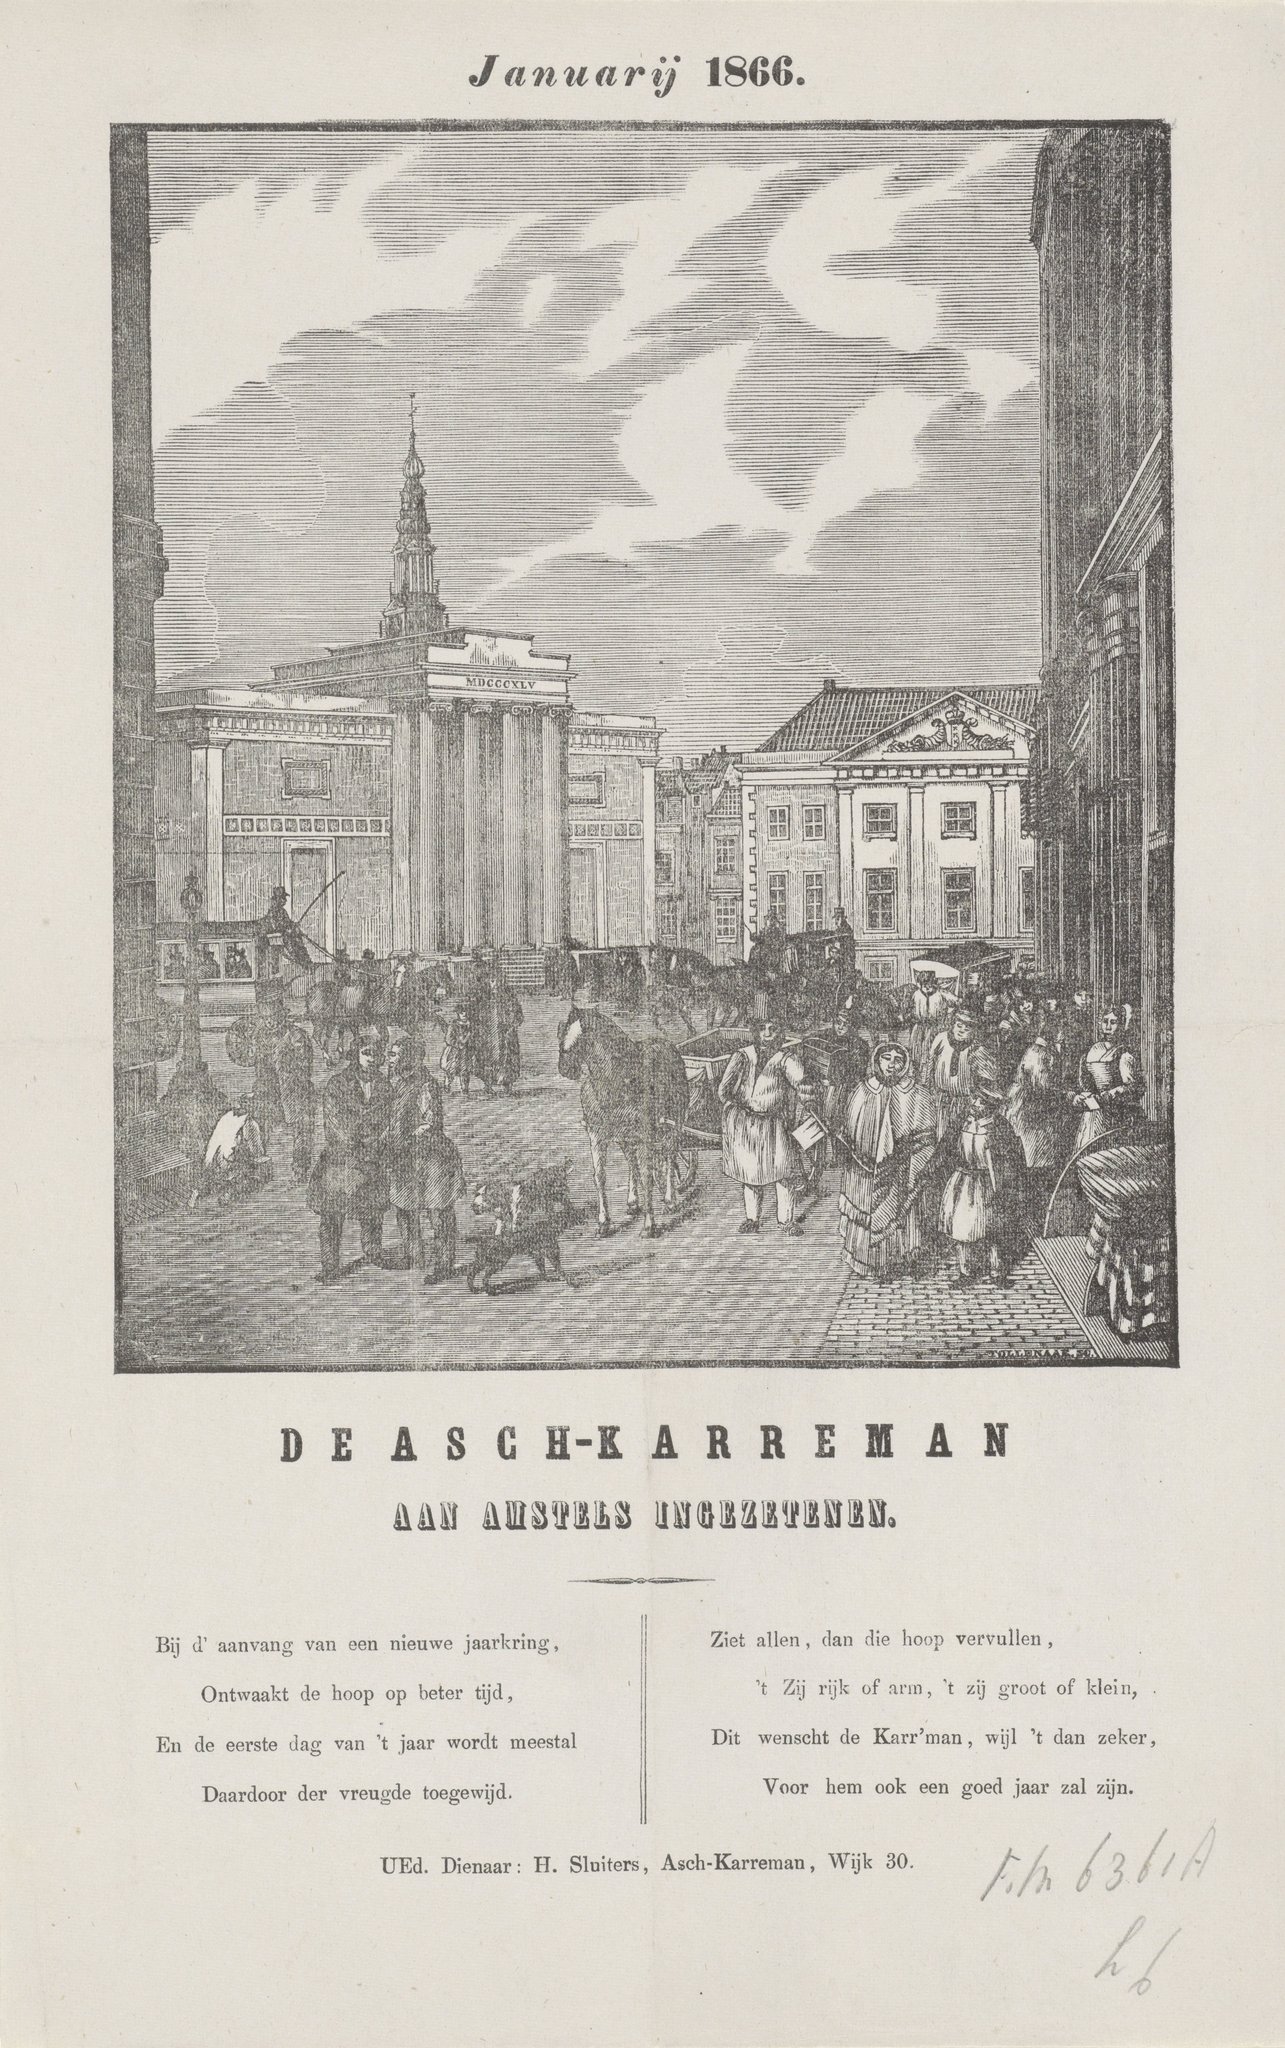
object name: print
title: Nieuwjaarswens van de Amsterdamse askarrenmannen voor het jaar 1866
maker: dirk wijbrand tollenaar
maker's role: print maker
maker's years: 1808-1858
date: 1865-1866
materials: paper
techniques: letterpress printing, engraving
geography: netherlands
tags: public road - ii - ideal city, garbage collection, amsterdam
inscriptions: collector's mark: Lugt 2228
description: Nieuwjaarswens namens de askarrenmannen (karrenman of vuilnisman) te Amsterdam voor het jaar 1866. Gezicht op de Dam te Amsterdam met de Beurs van Zocher en het Commandantshuis. Tussen het publiek de vuilnismannen met hun kar. Onderaan een gedicht in twee kolommen. Namens H. Sluiters, de askarreman van wijk no. 30.